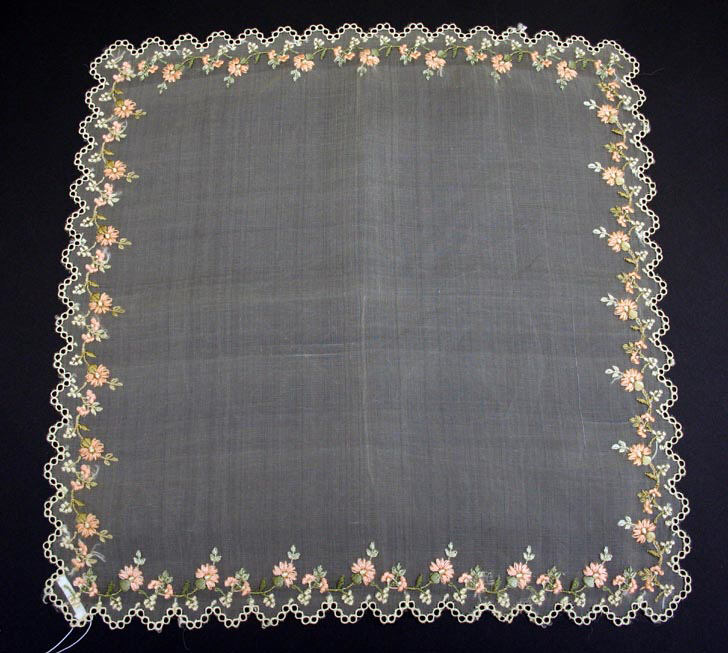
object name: handkerchief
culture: american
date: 1882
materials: cotton